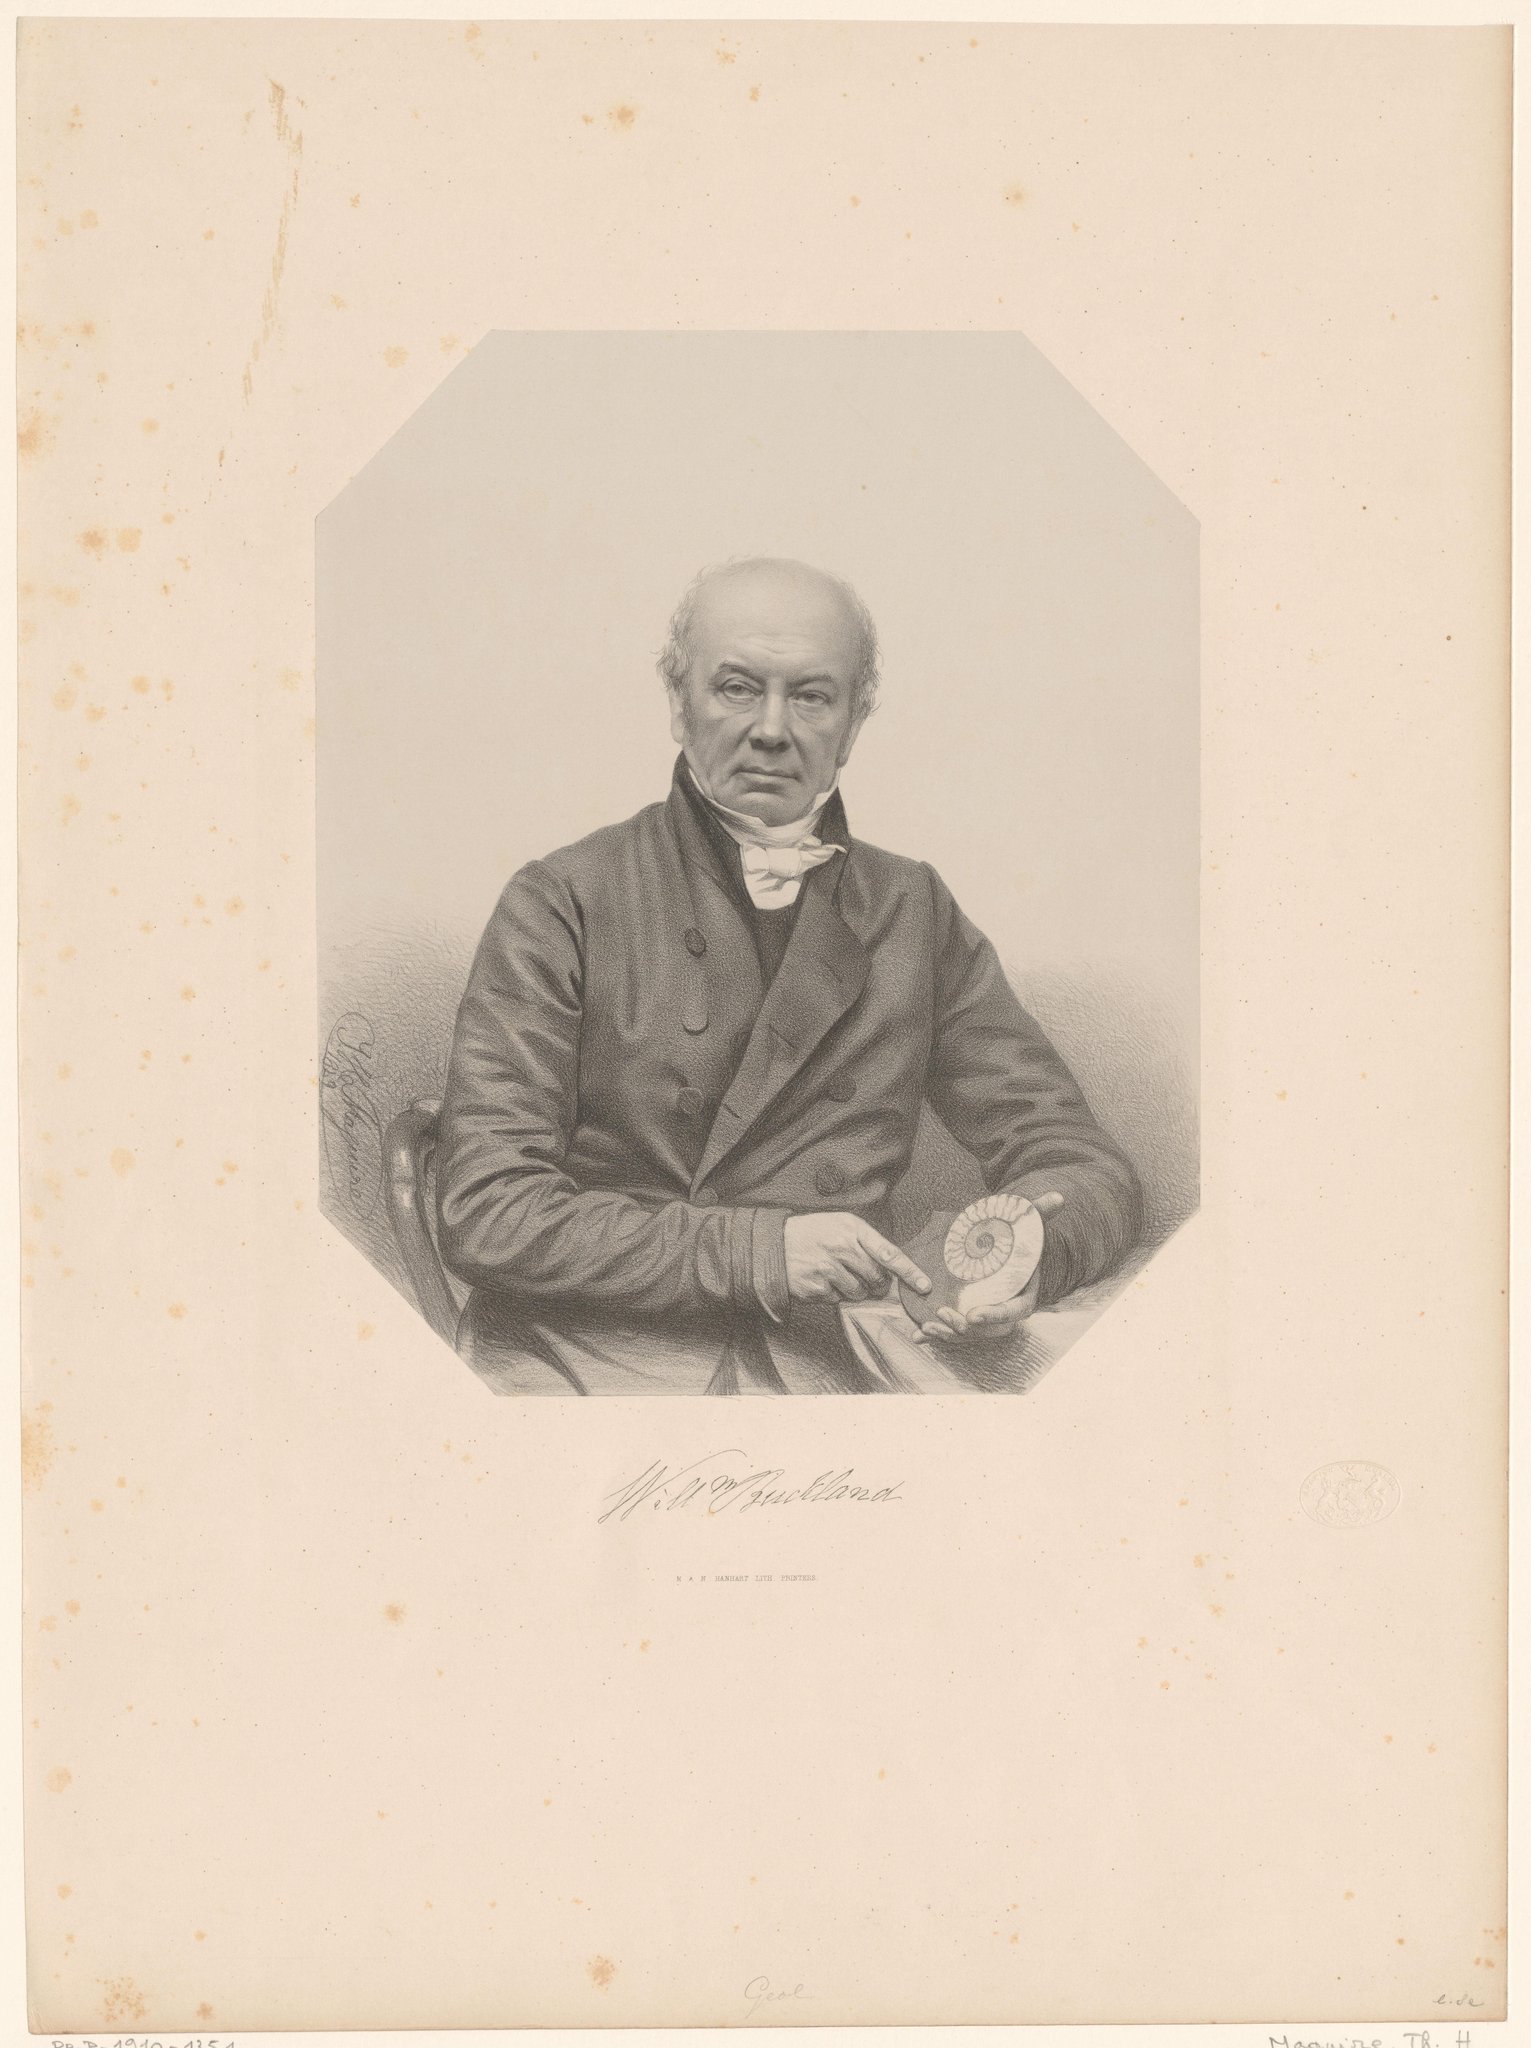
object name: print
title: Ipswich Museum Portraits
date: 1852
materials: paper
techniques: lithograph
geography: london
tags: physicist, adult man, rock types of animal or plant origin, historical persons, scallop, shell ~ ornament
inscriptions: check stamp: ‘Ipswich Museum’, collector's mark: Lugt 2228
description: Prent behoort tot de serie 'Ipswich Museum Portraits', ook bekend onder de titel 'Portraits of Honorary Members of the Ipswich Museum'. Deze serie is in 1852 door George Ransome uitgegeven en gedrukt door M&N Hanhart tussen 1848 en 1852. De serie bestaat uit ca. 60 portretten.